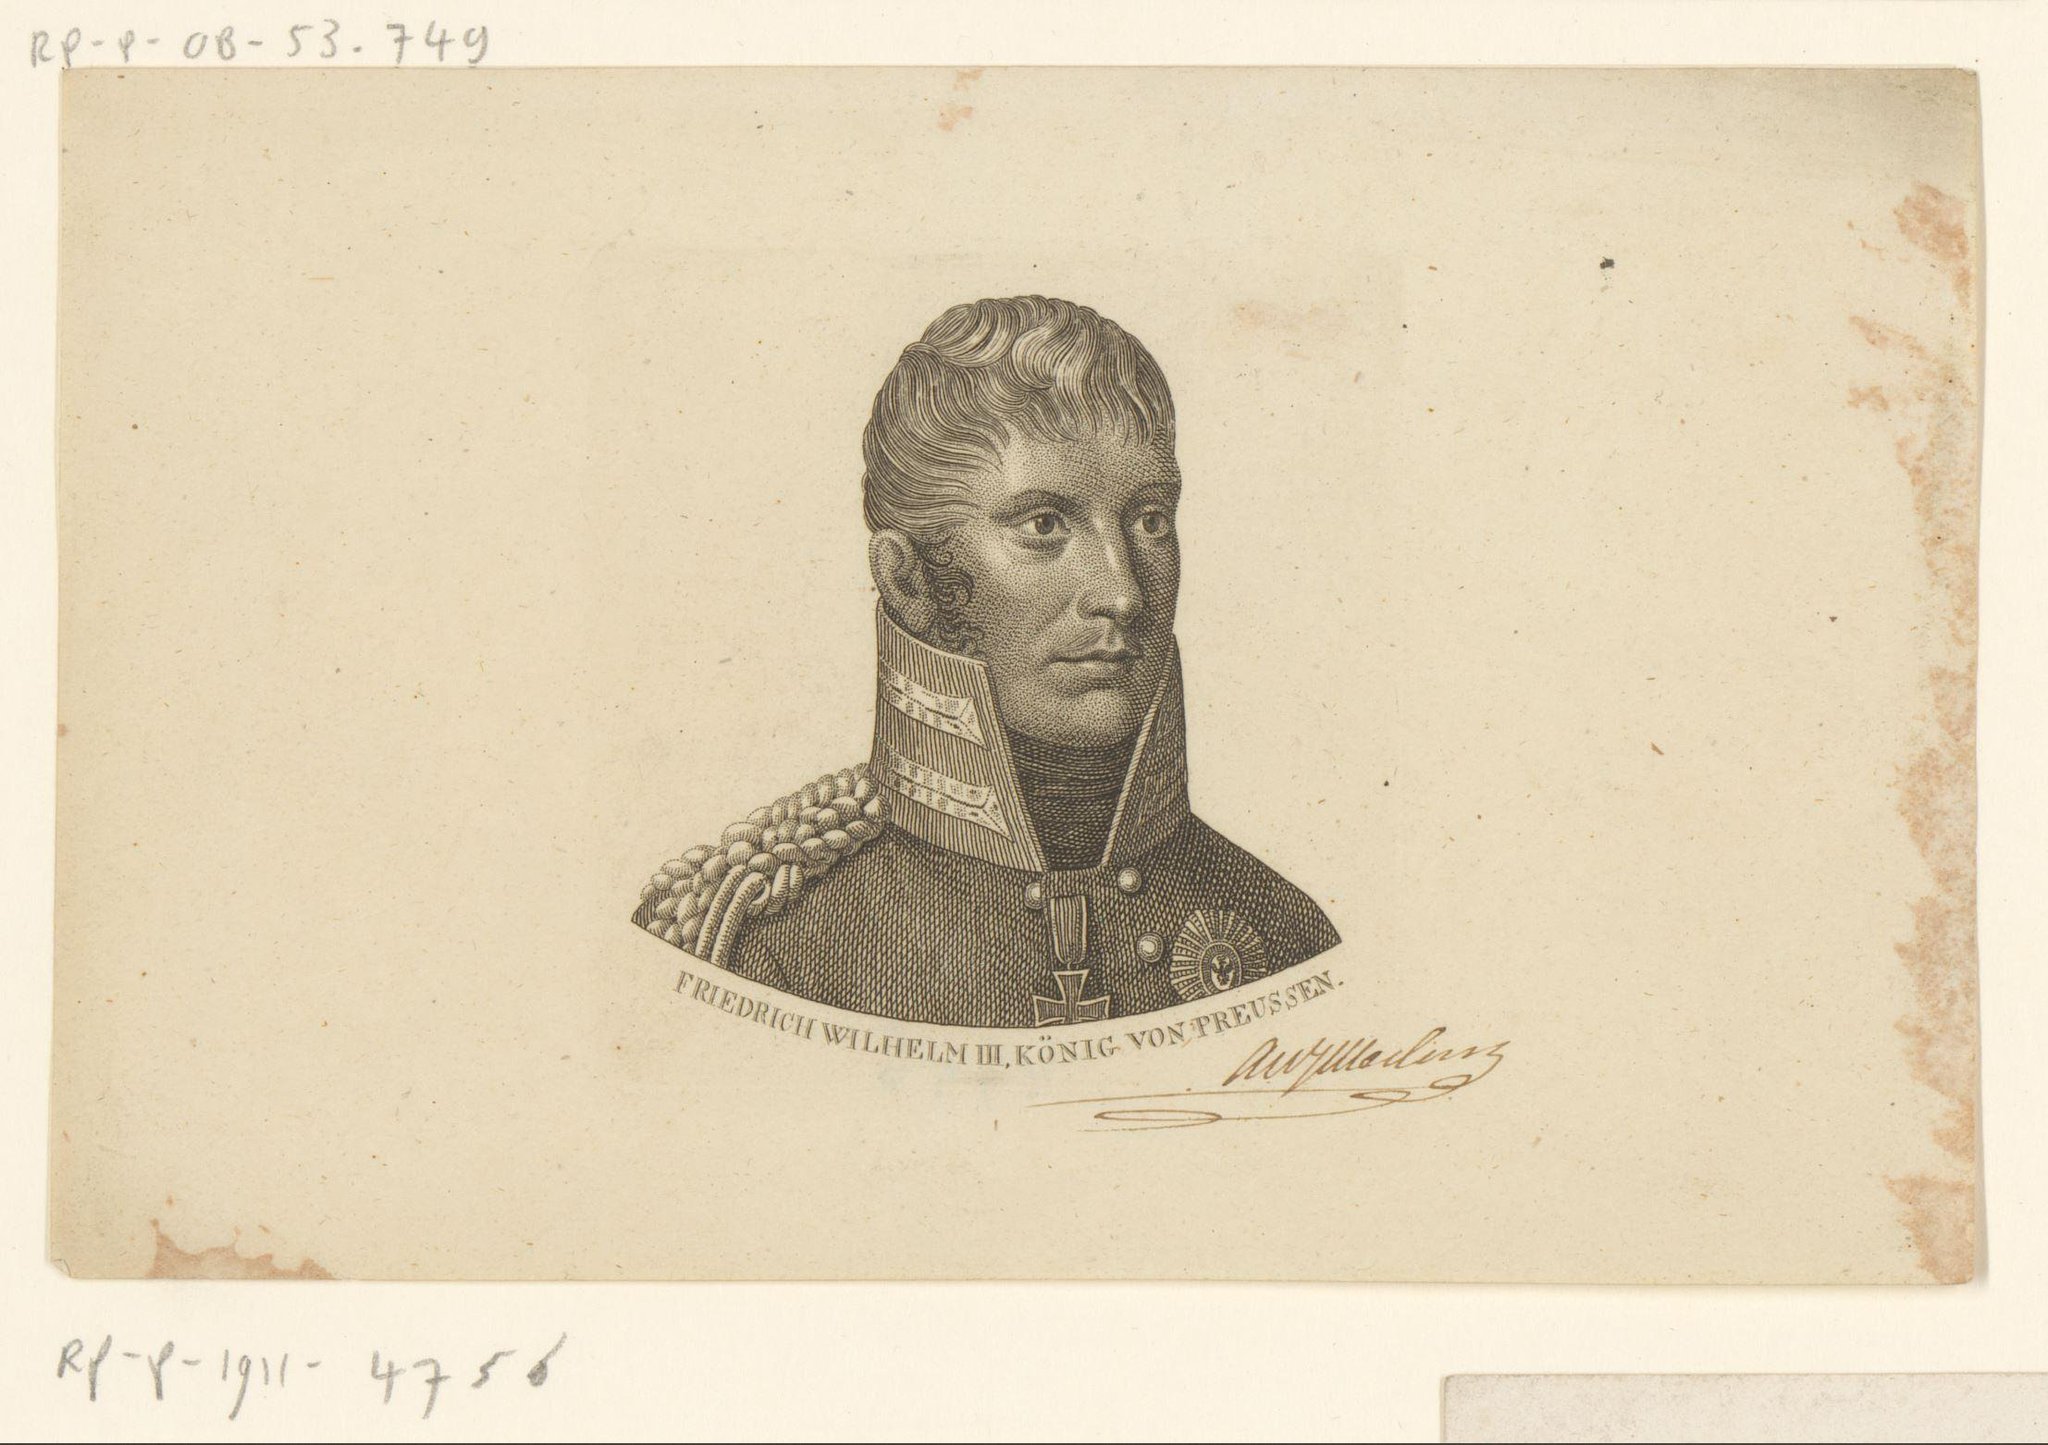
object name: print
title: Portret van Frederik Willem III koning van Pruisen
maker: ernst ludwig riepenhausen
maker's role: print maker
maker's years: 1765-1840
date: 1797-1840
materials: paper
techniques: engraving, etching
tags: berlin, frederik willem iii koning van pruisen, historical persons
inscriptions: signature, collector's mark: Lugt 2228